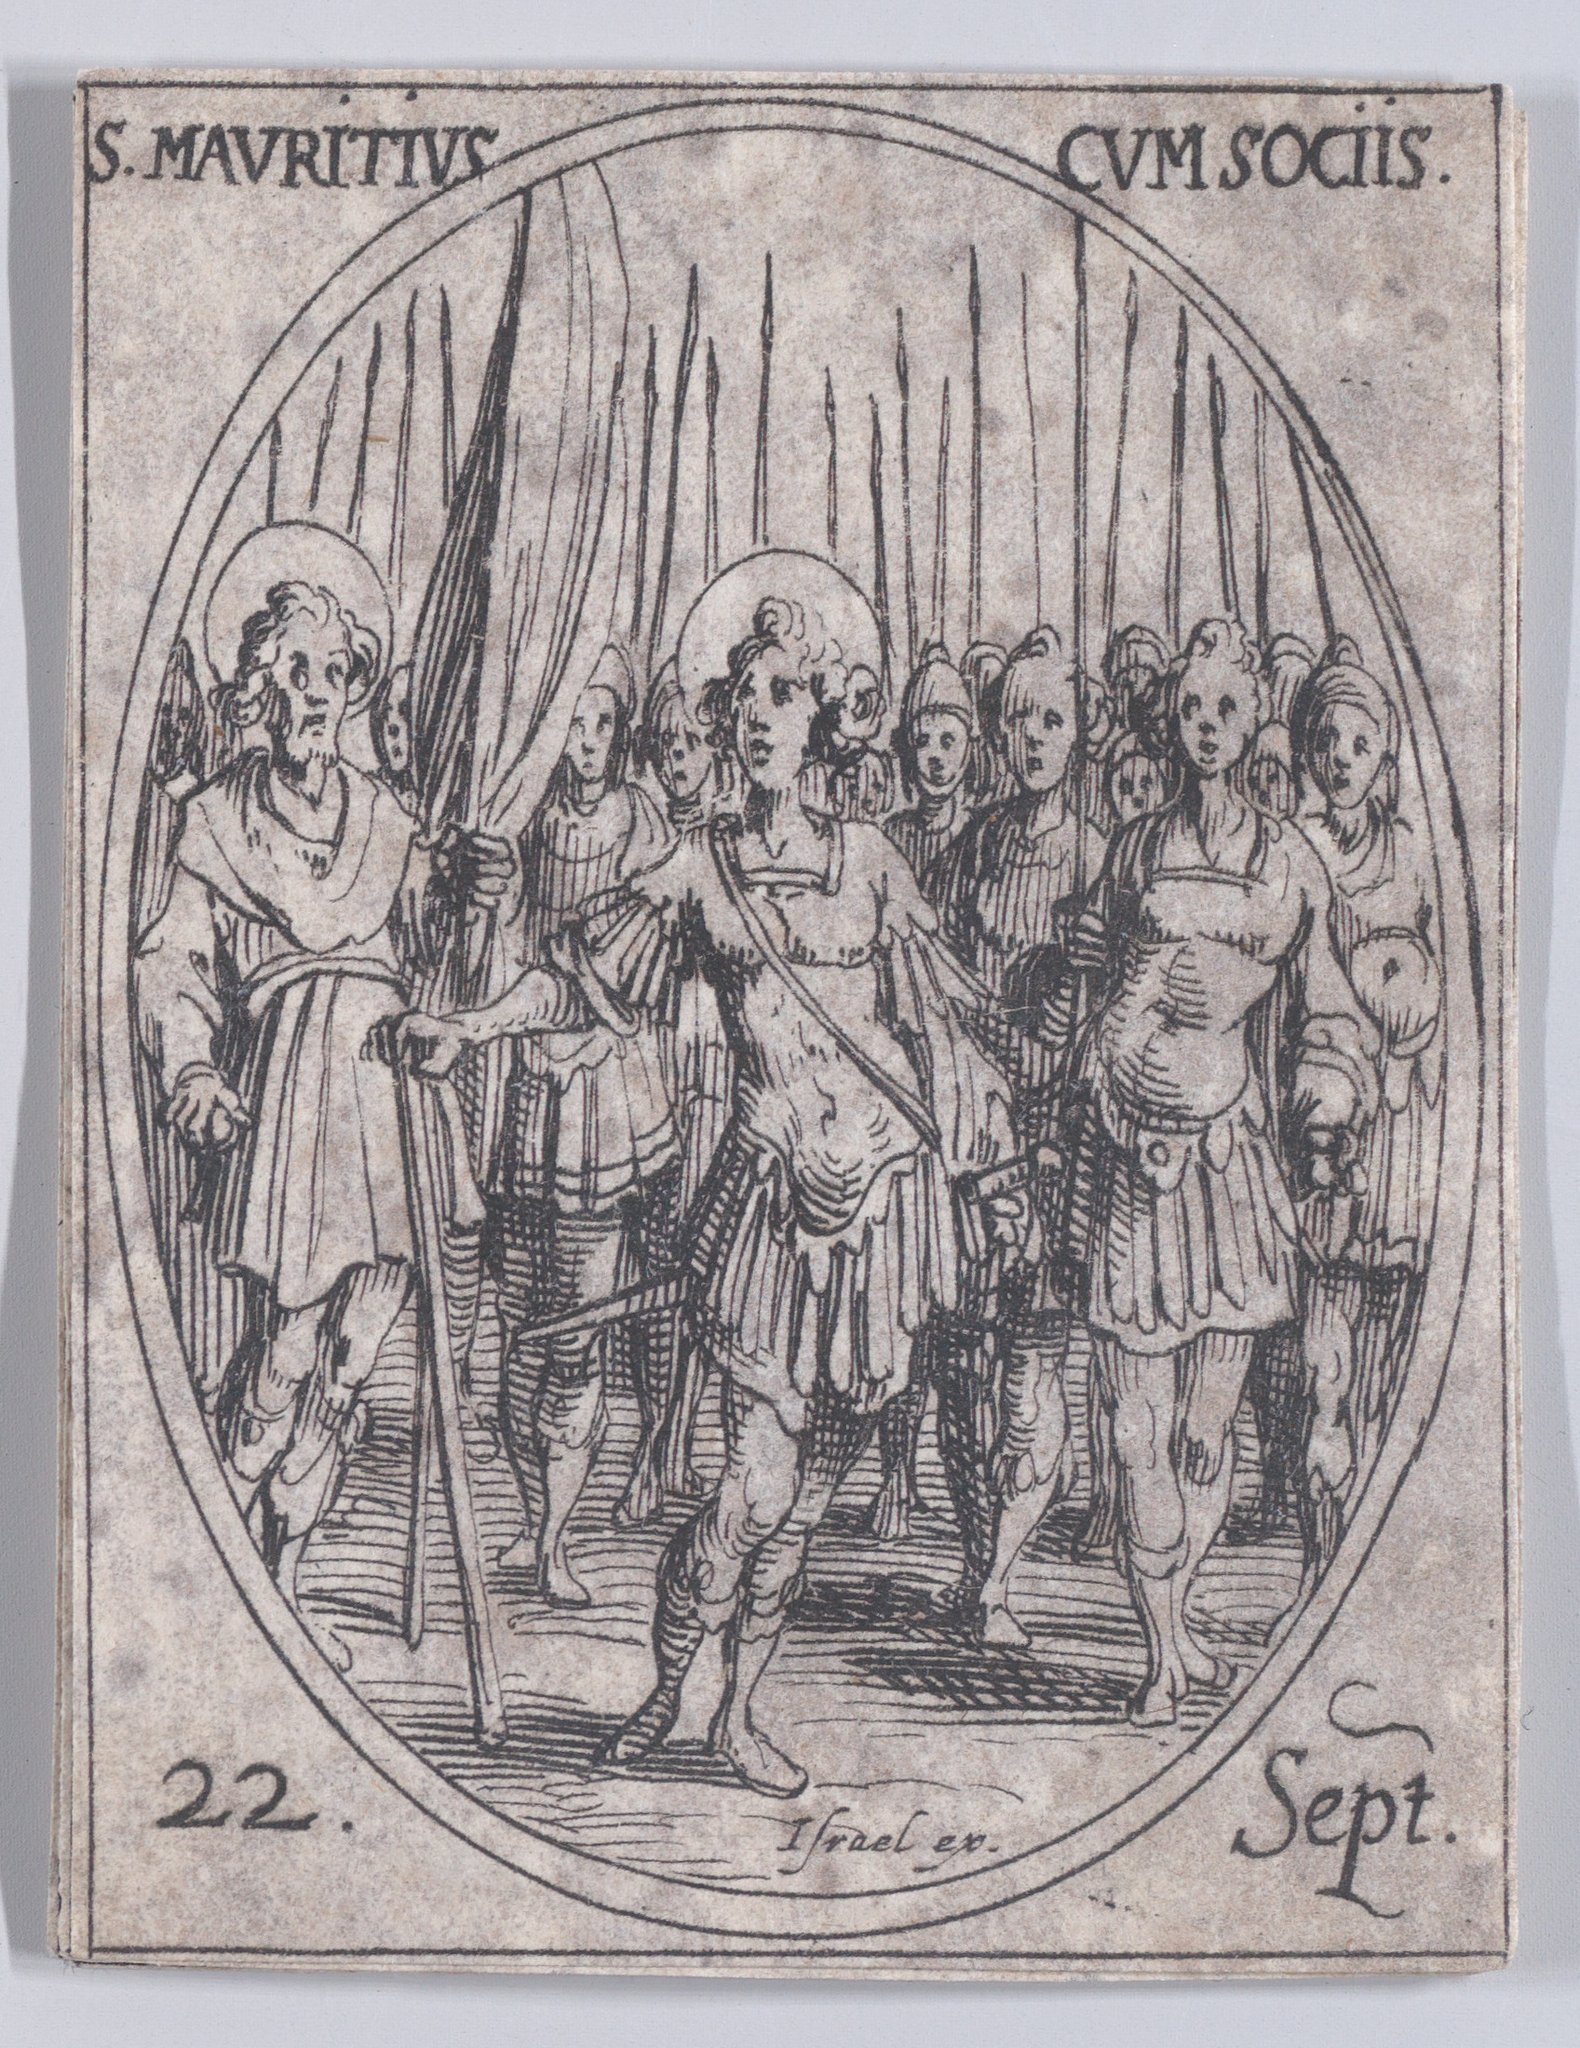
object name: print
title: S. Maurice et Ses Compagnons (St. Maurice and His Companions), September 22nd, from "Les Images De Tous Les Saincts et Saintes de L'Année" (Images of All of the Saints and Religious Events of the Year)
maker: jacques callot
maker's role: artist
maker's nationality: french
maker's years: 1592-1635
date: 1636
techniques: etching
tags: men,saints